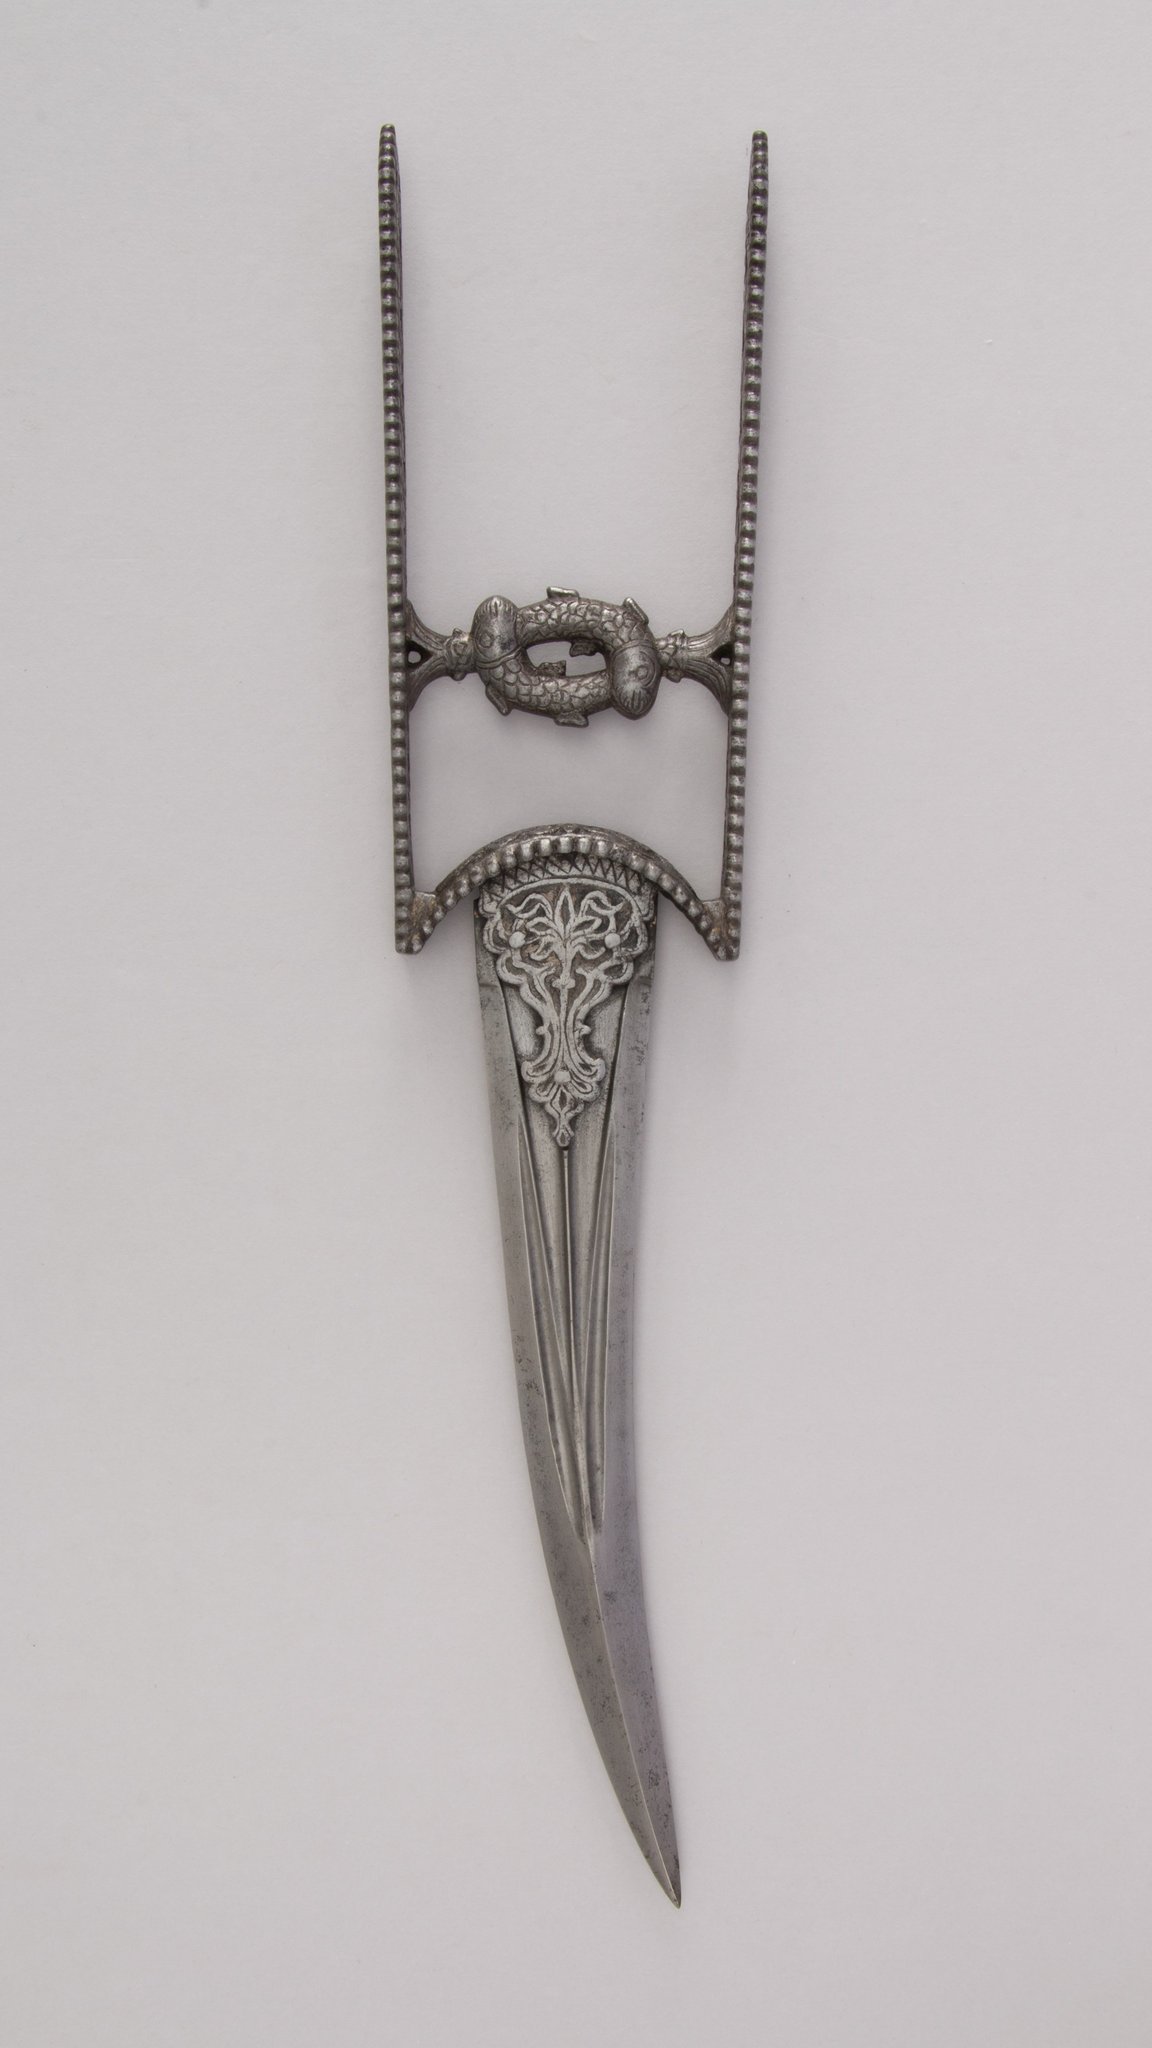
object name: dagger katar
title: Dagger (Katar)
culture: indian, mughal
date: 1701-1800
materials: steel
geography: india